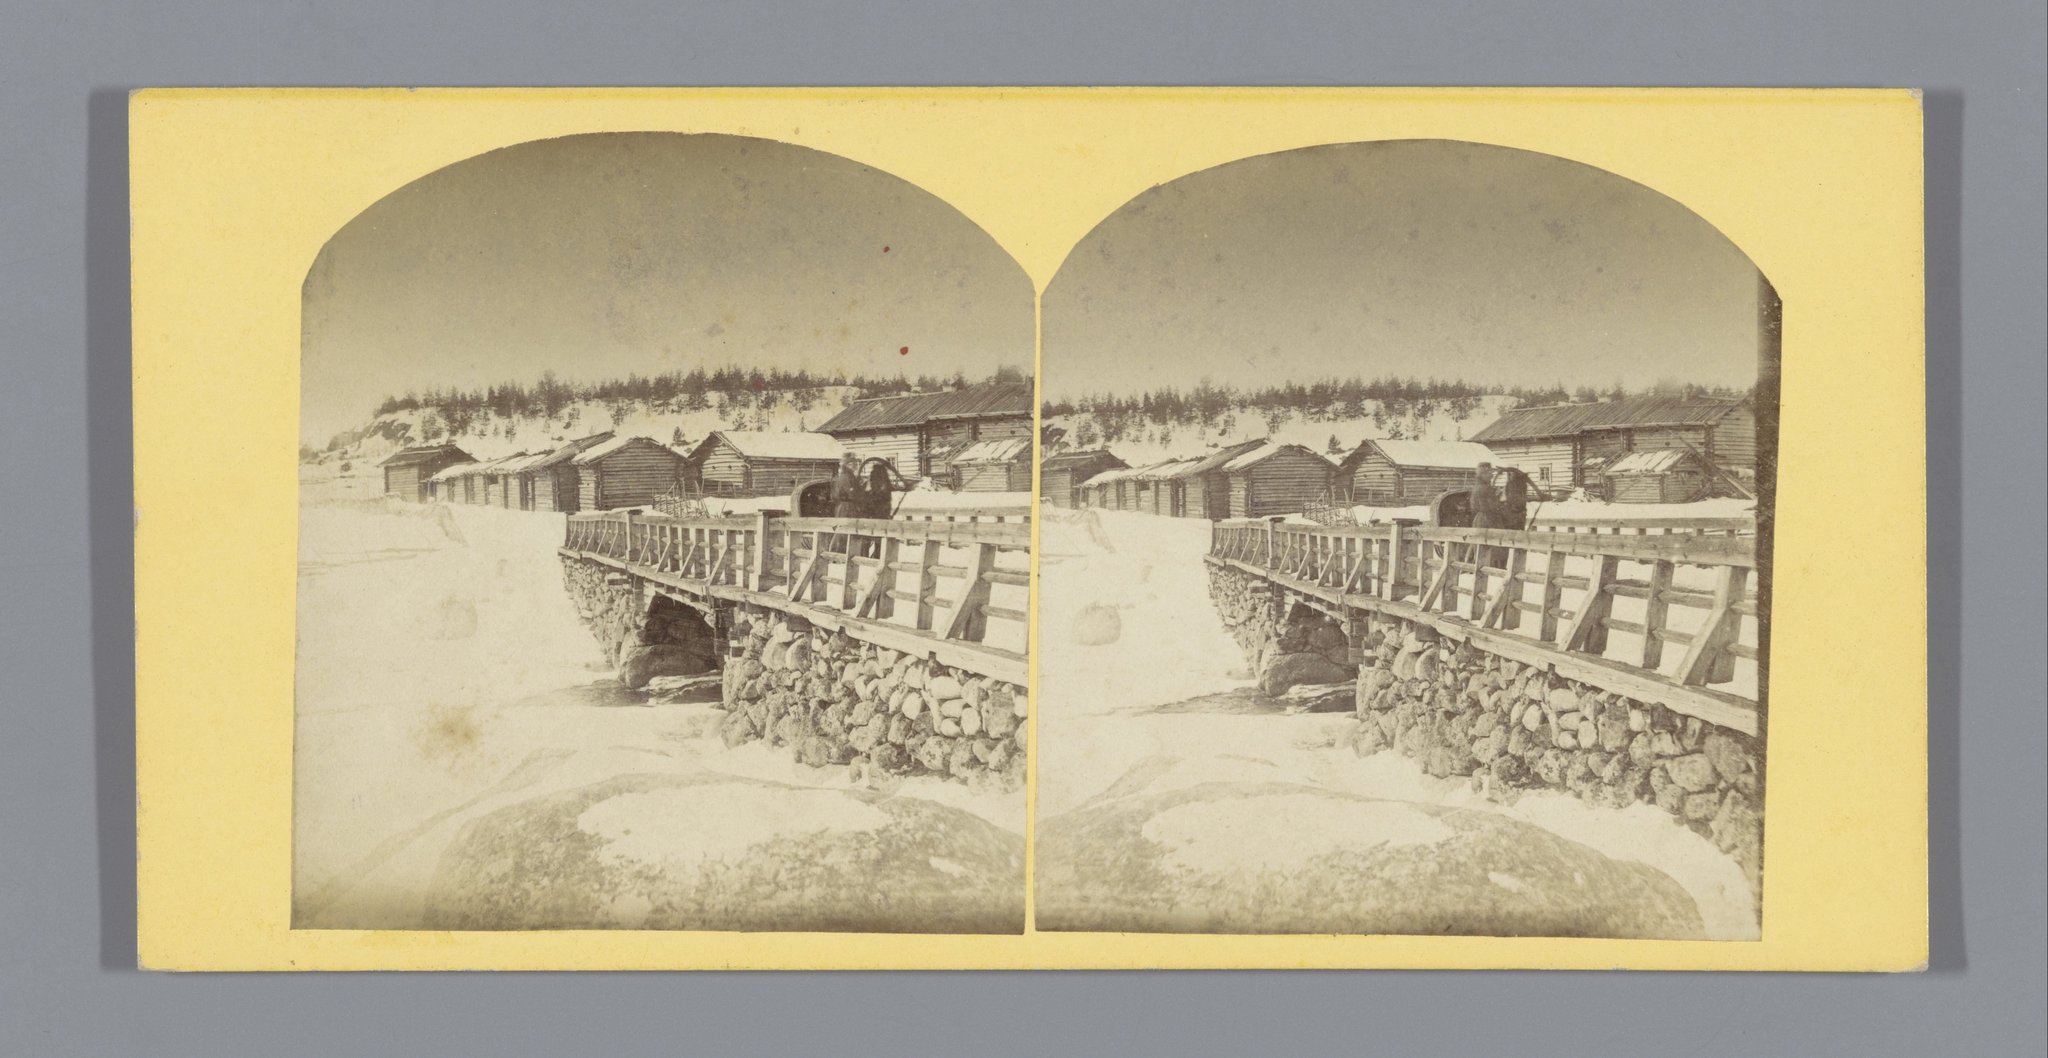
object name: stereograph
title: Finlande, Effet de Neige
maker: Anonymous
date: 1861-1870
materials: cardboard, paper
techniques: albumen print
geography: finland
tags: village, snow